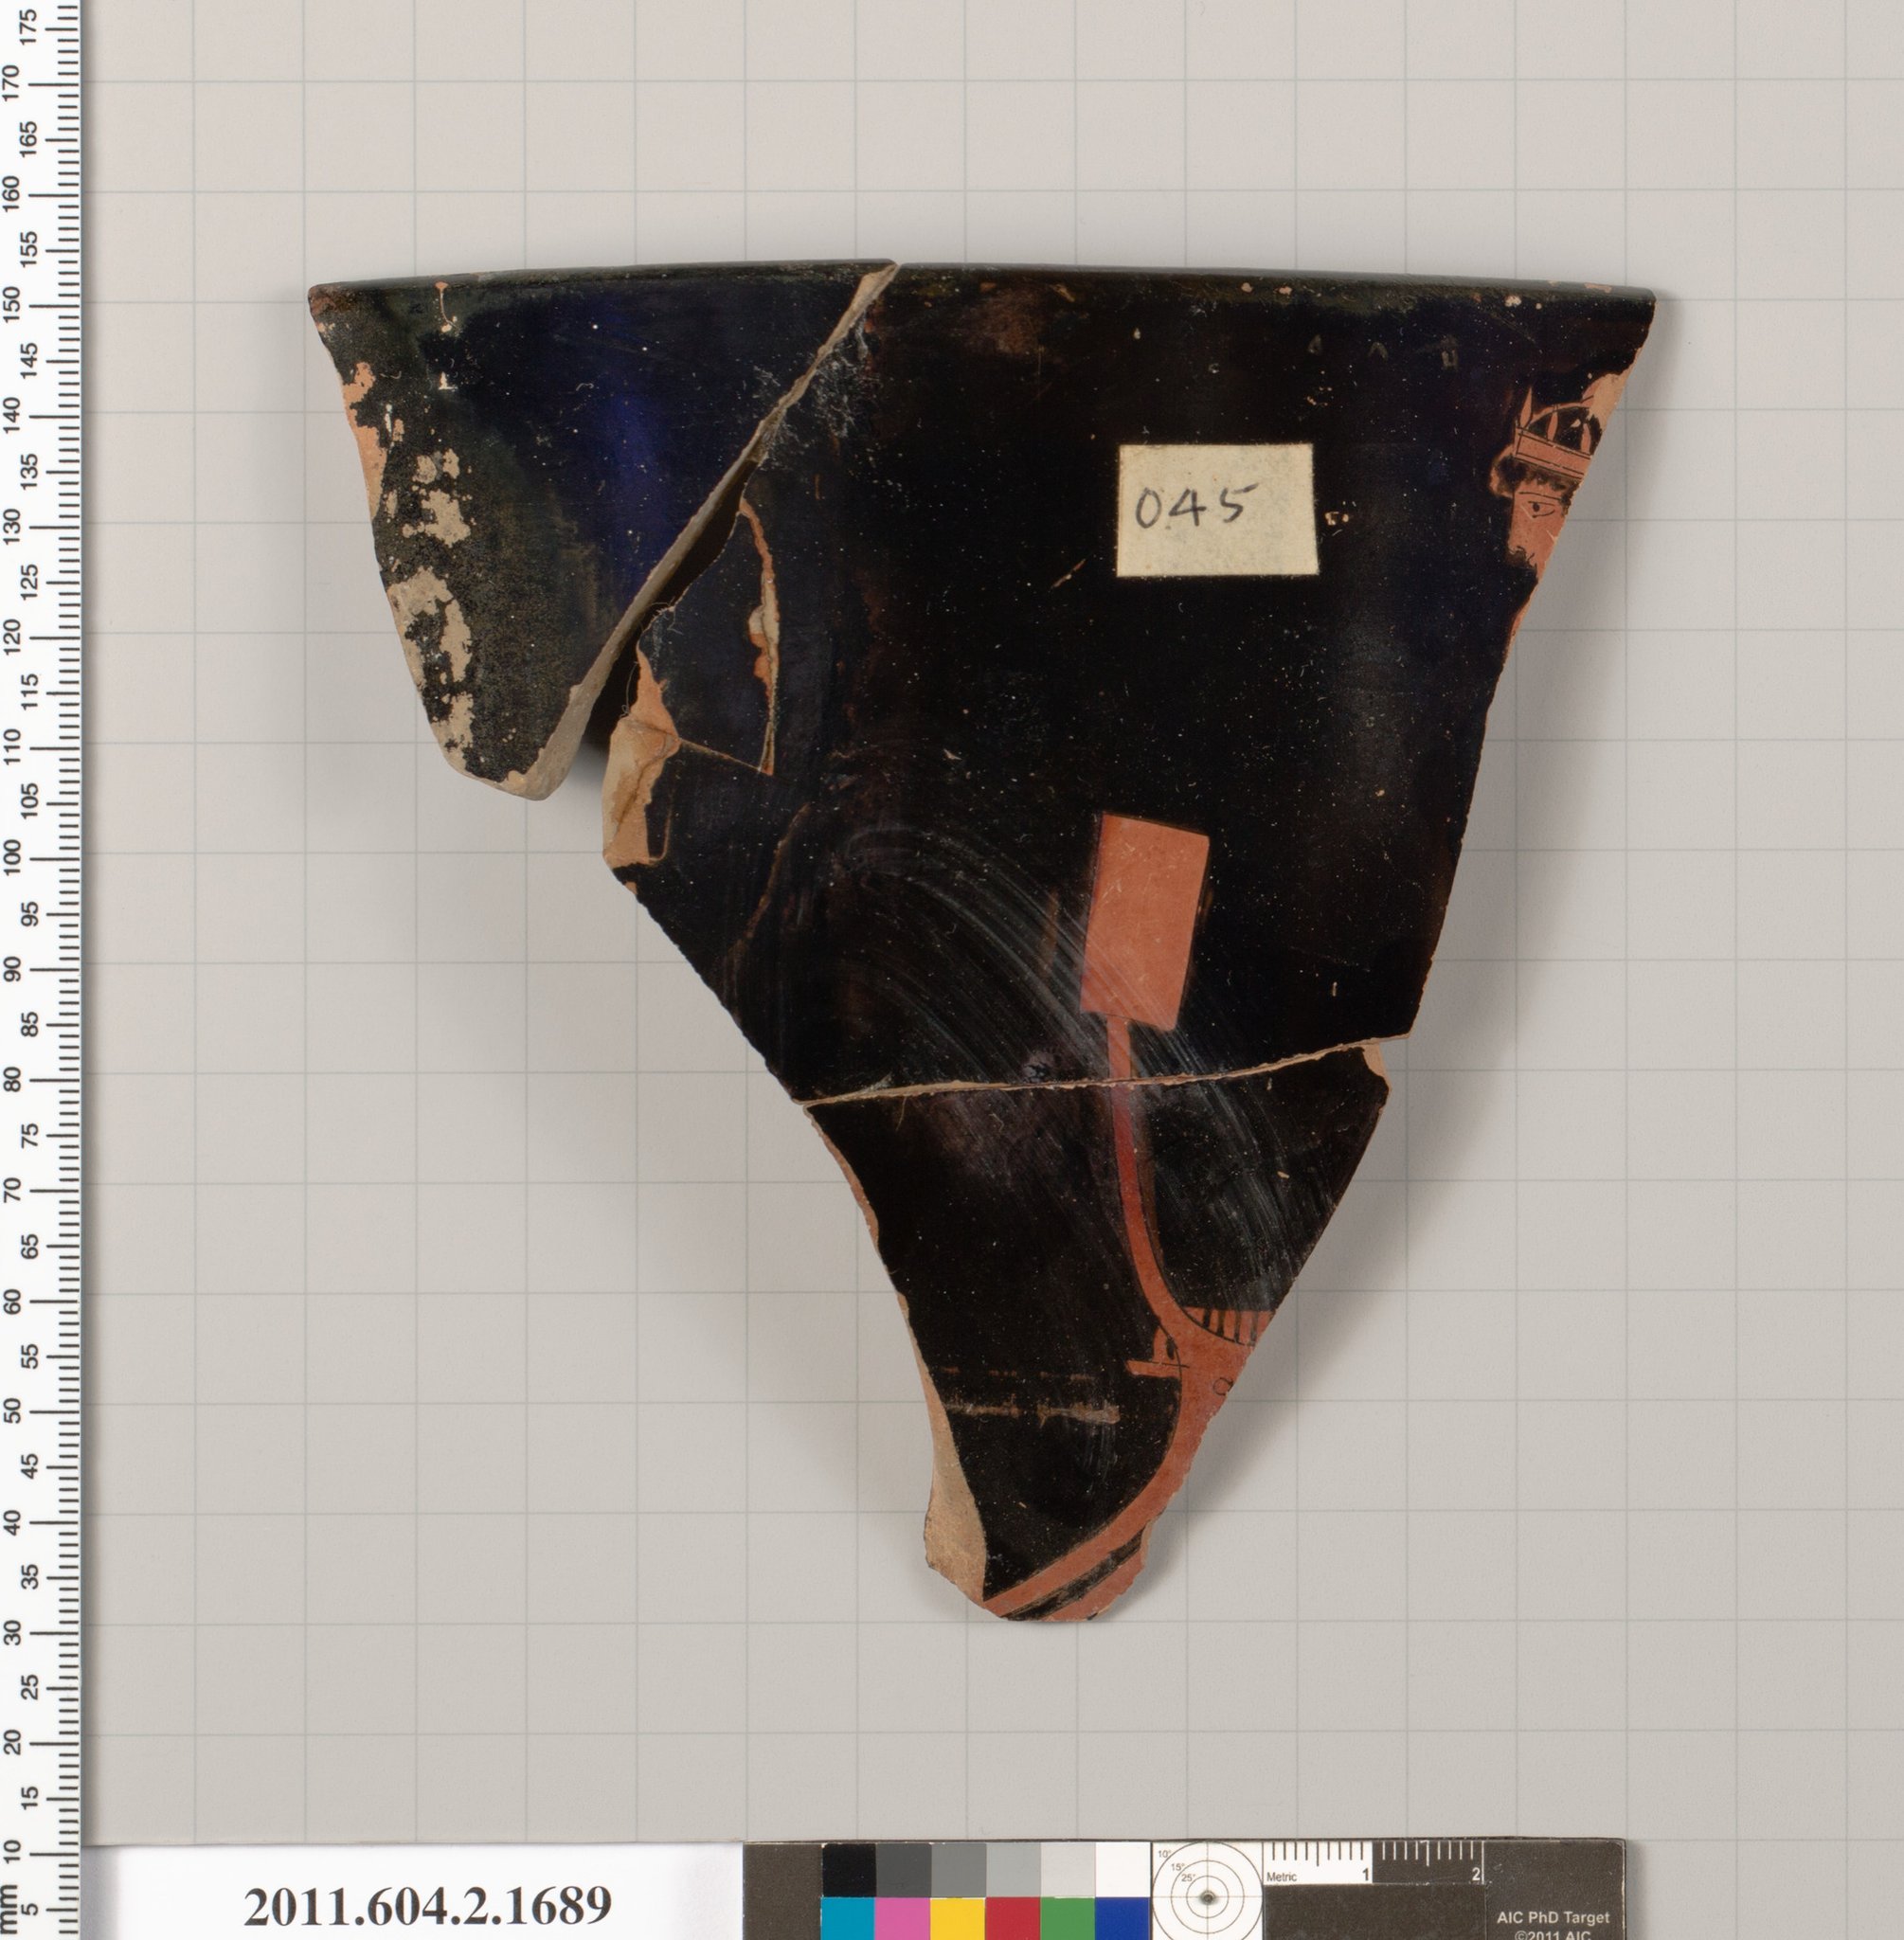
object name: skyphos fragment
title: Terracotta fragment of a skyphos (deep drinking cup)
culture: greek, attic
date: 470-460 BCE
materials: terracotta